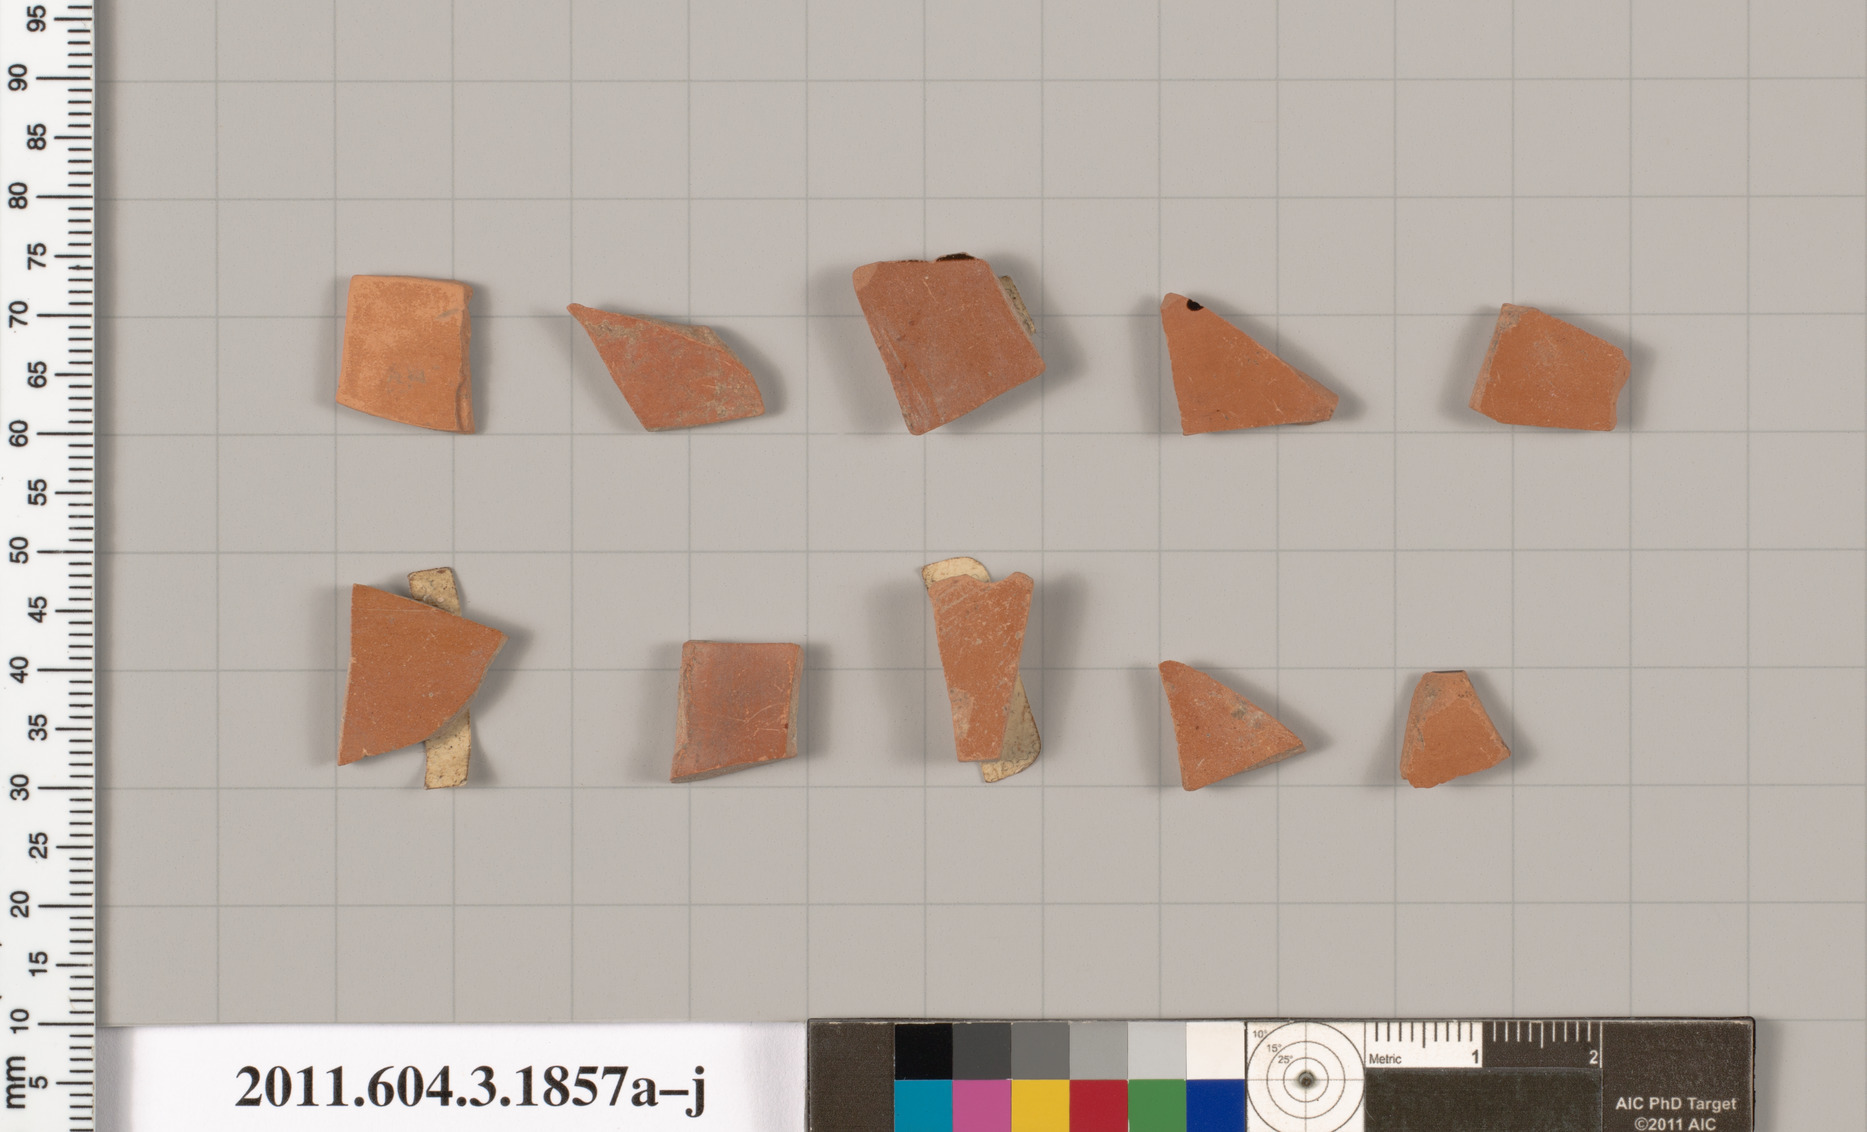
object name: kylix fragment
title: Terracotta fragments of kylikes: Band or lip cups (drinking cups)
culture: greek, attic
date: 560-525 BCE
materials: terracotta